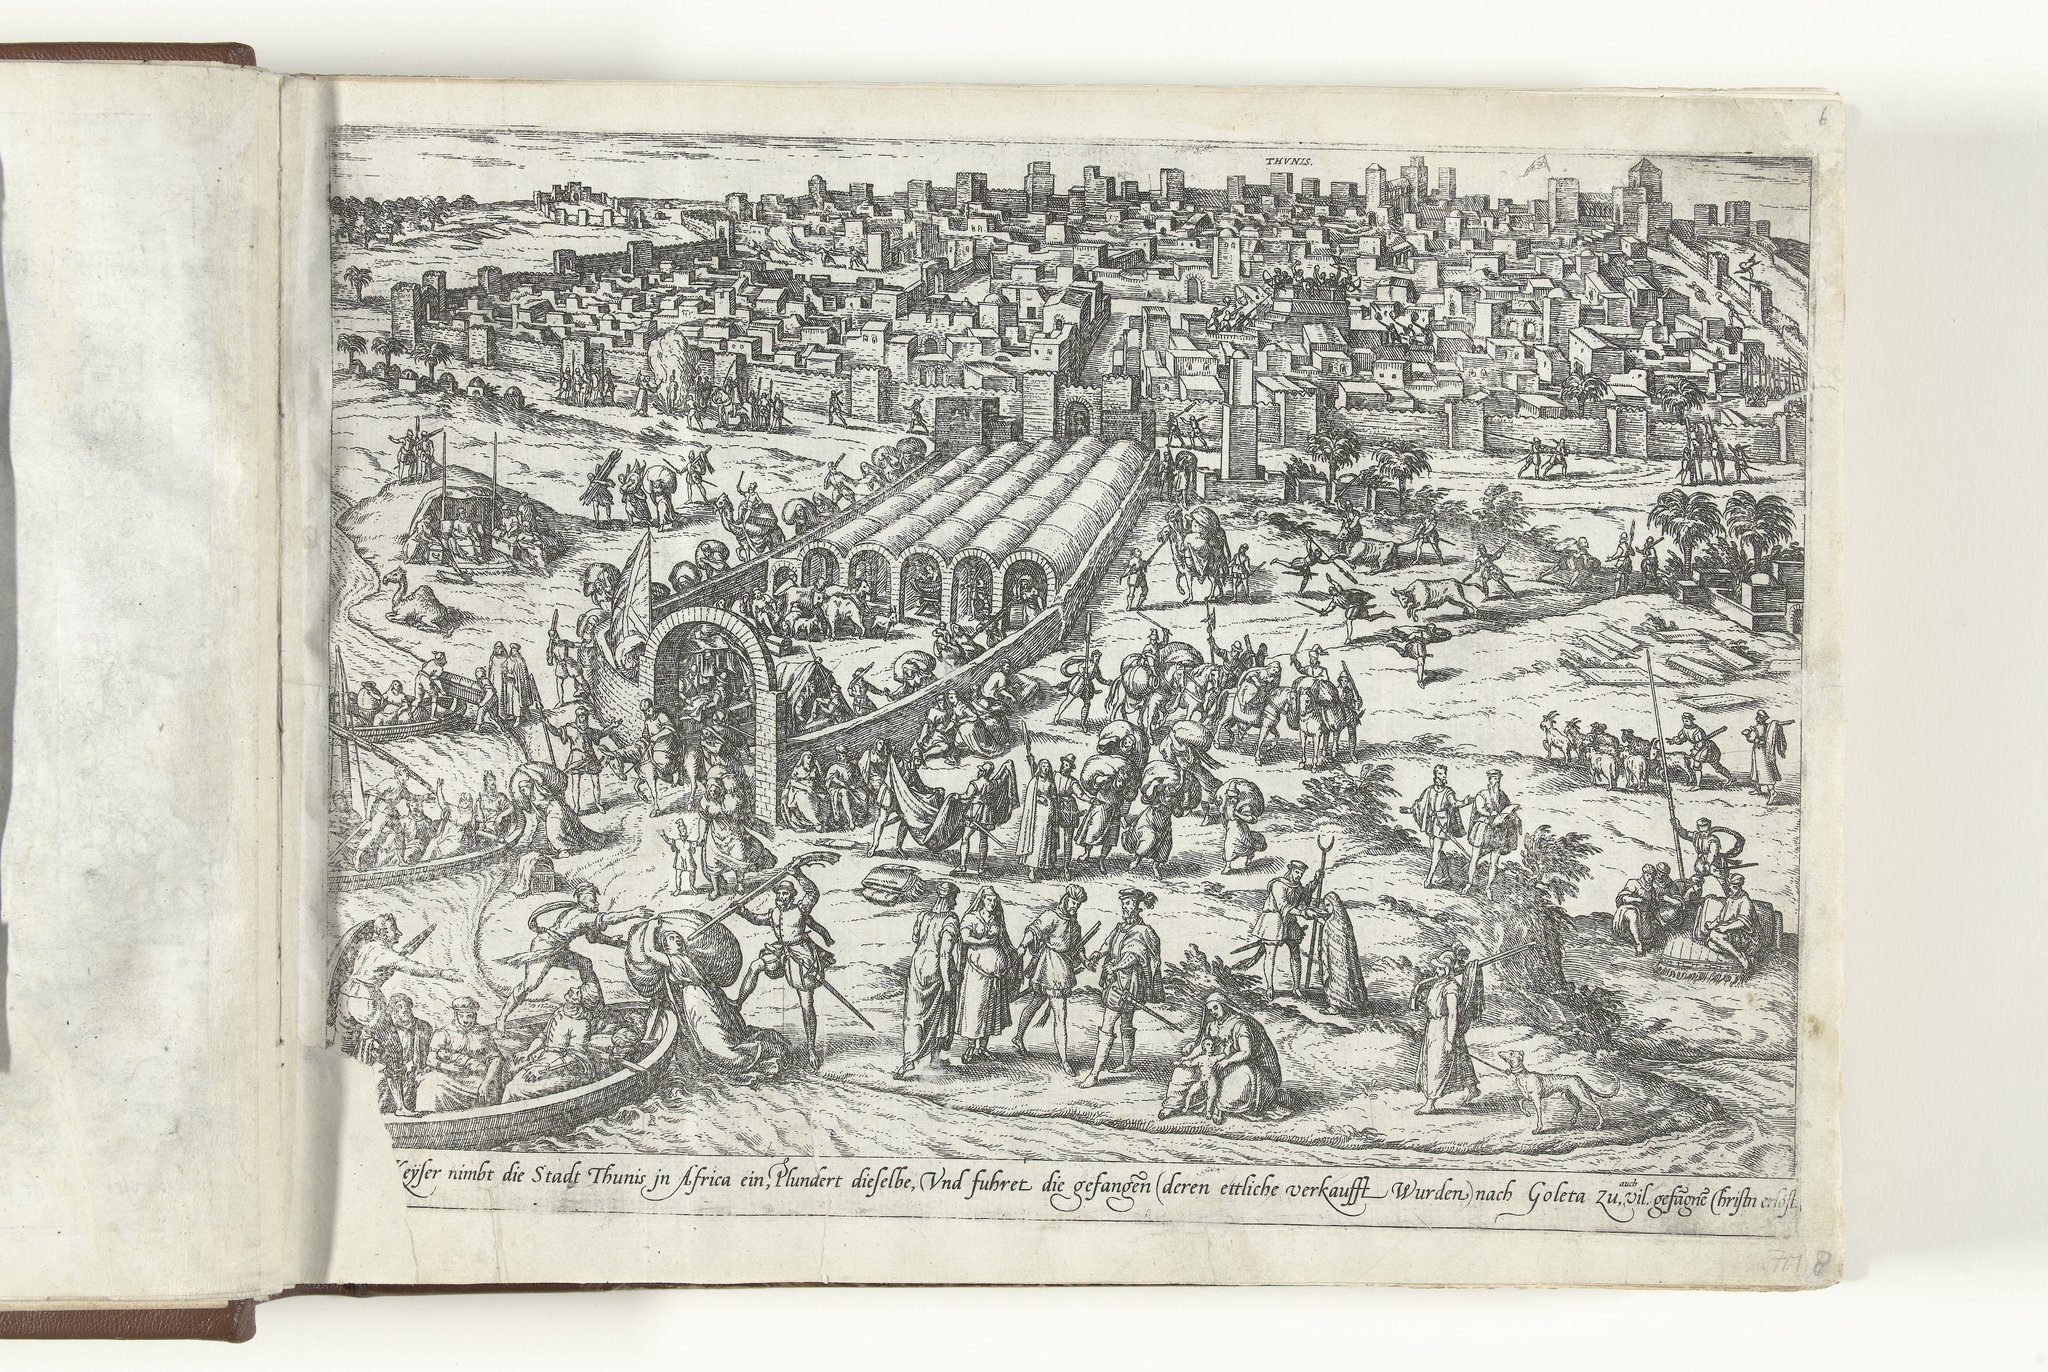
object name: print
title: Kurtze erzeichniss wie Keyser Carolus der V. in Africa Dem Konig von Thunis, so von dem Barbarossen vertrieben, mit kriegsrustu[n]g zur hulffe komt, und was sich zugedragen, kont ihr in diese folgende figurn fein ordentlich nach ein ander sehen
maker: frans hogenberg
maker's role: print maker, publisher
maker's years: 1538-1590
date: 1574-1578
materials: paper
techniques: etching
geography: cologne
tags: ghent, charles v (holy roman emperor and king of spain)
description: De keizerlijke troepen nemen Tunis in, 1535. Sommige bewoners ontvluchten de stad in kleine bootjes. Op de achtergrond de ommuurde stad. Hoek linksonder met nummer [6] ontbreekt.